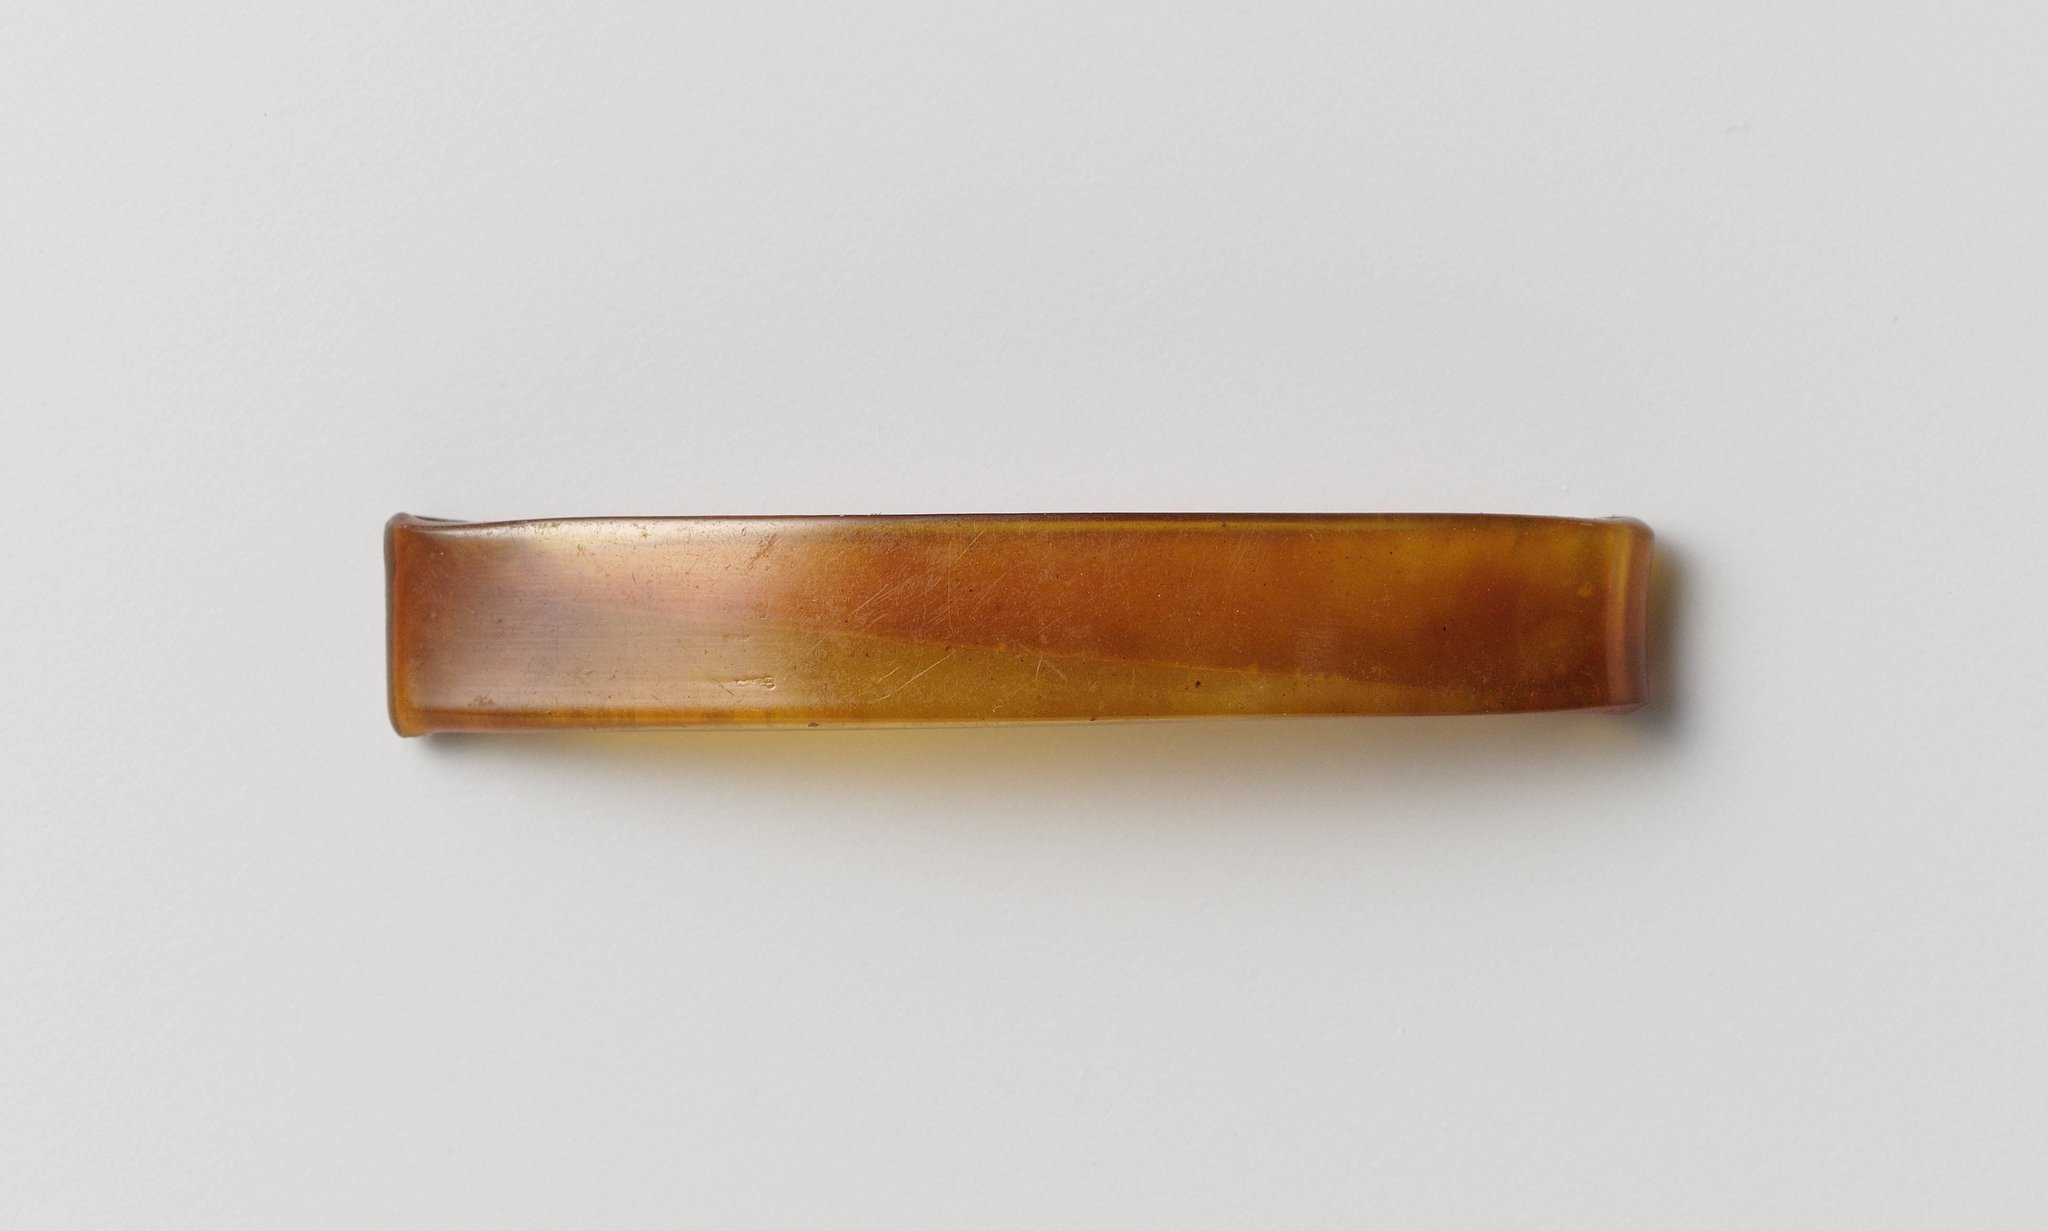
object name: hairpin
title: Haarspeld van bruine kunststof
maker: Anonymous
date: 1875-1900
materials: plastic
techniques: cutting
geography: netherlands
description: Enkele haarspeld van onversierde bruine kunststof.